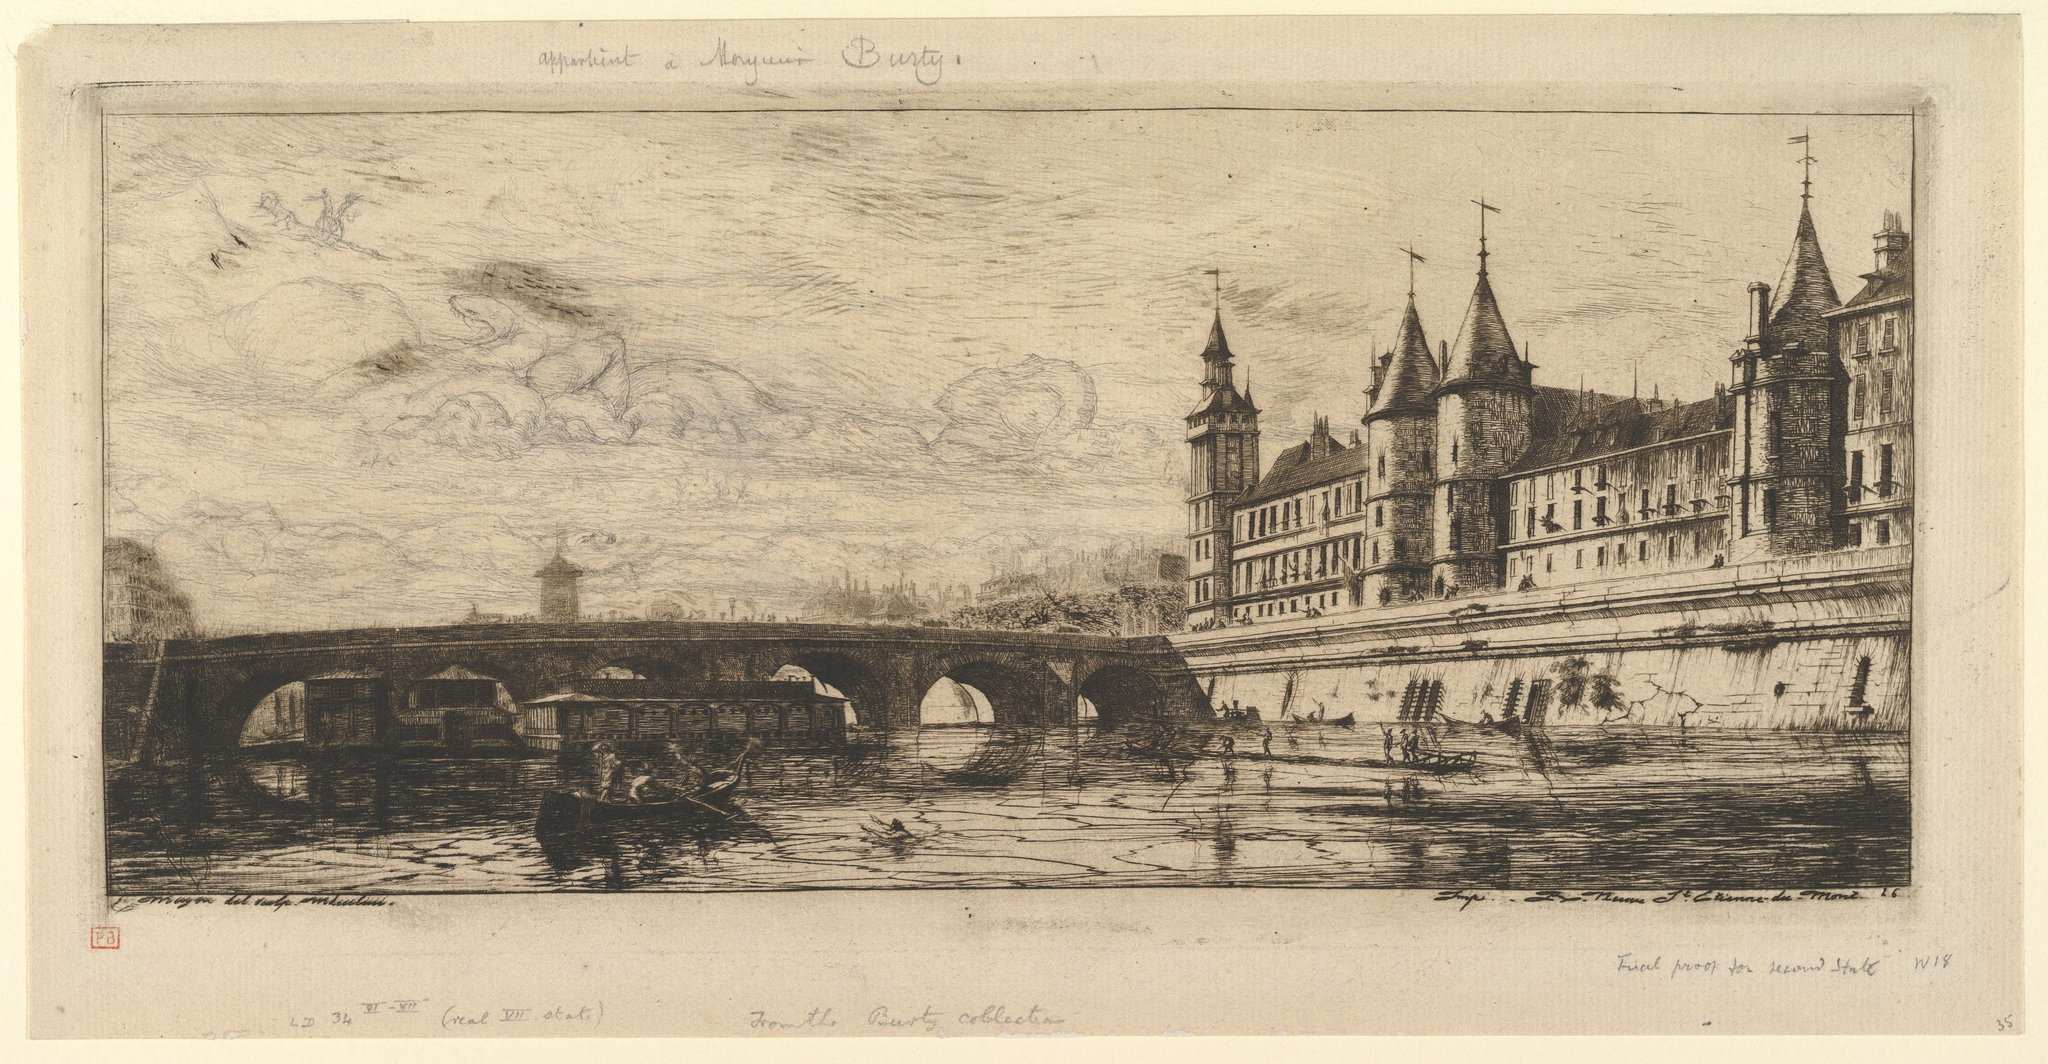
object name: print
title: Le Pont au Change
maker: charles meryon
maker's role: artist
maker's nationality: french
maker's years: 1821-1868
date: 1854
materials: graphite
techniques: etching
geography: france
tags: buildings,bridges,boats